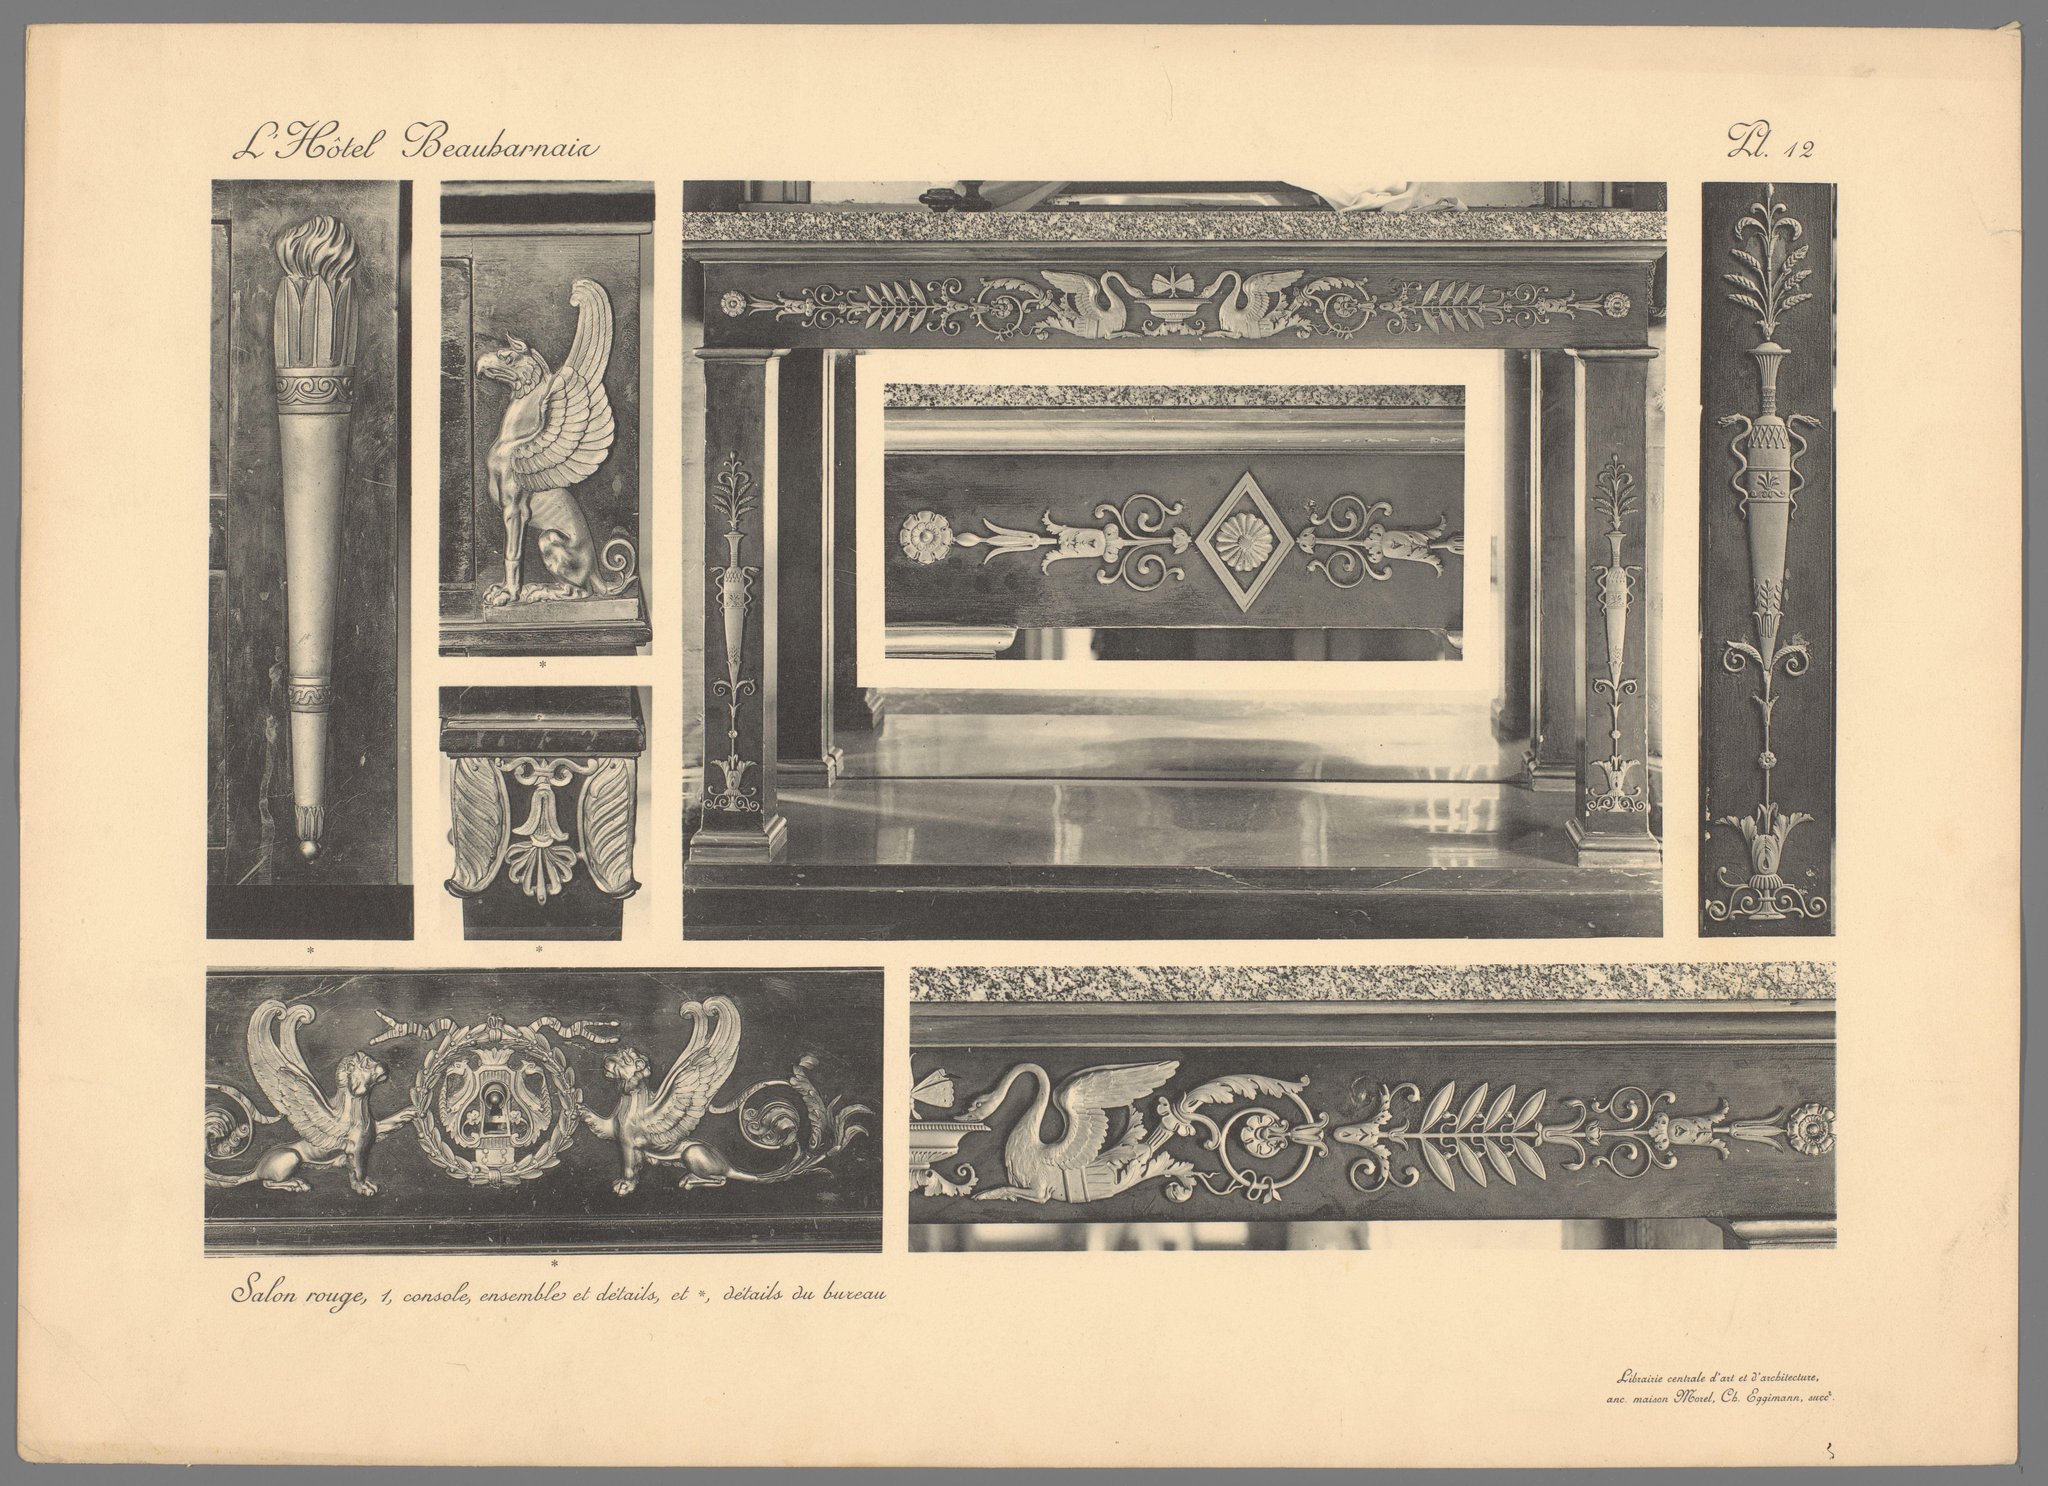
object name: photomechanical print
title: Salon rouge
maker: Anonymous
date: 1875-1930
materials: paper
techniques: photograph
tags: ornament derived from plant forms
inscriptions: number: ‘12’, collector's mark: ‘Rijks normaalschool voor teekenonderwijzers Amsterdam’, inscription: ‘1, concole, ensemble et détails, et *, détails du bureau’